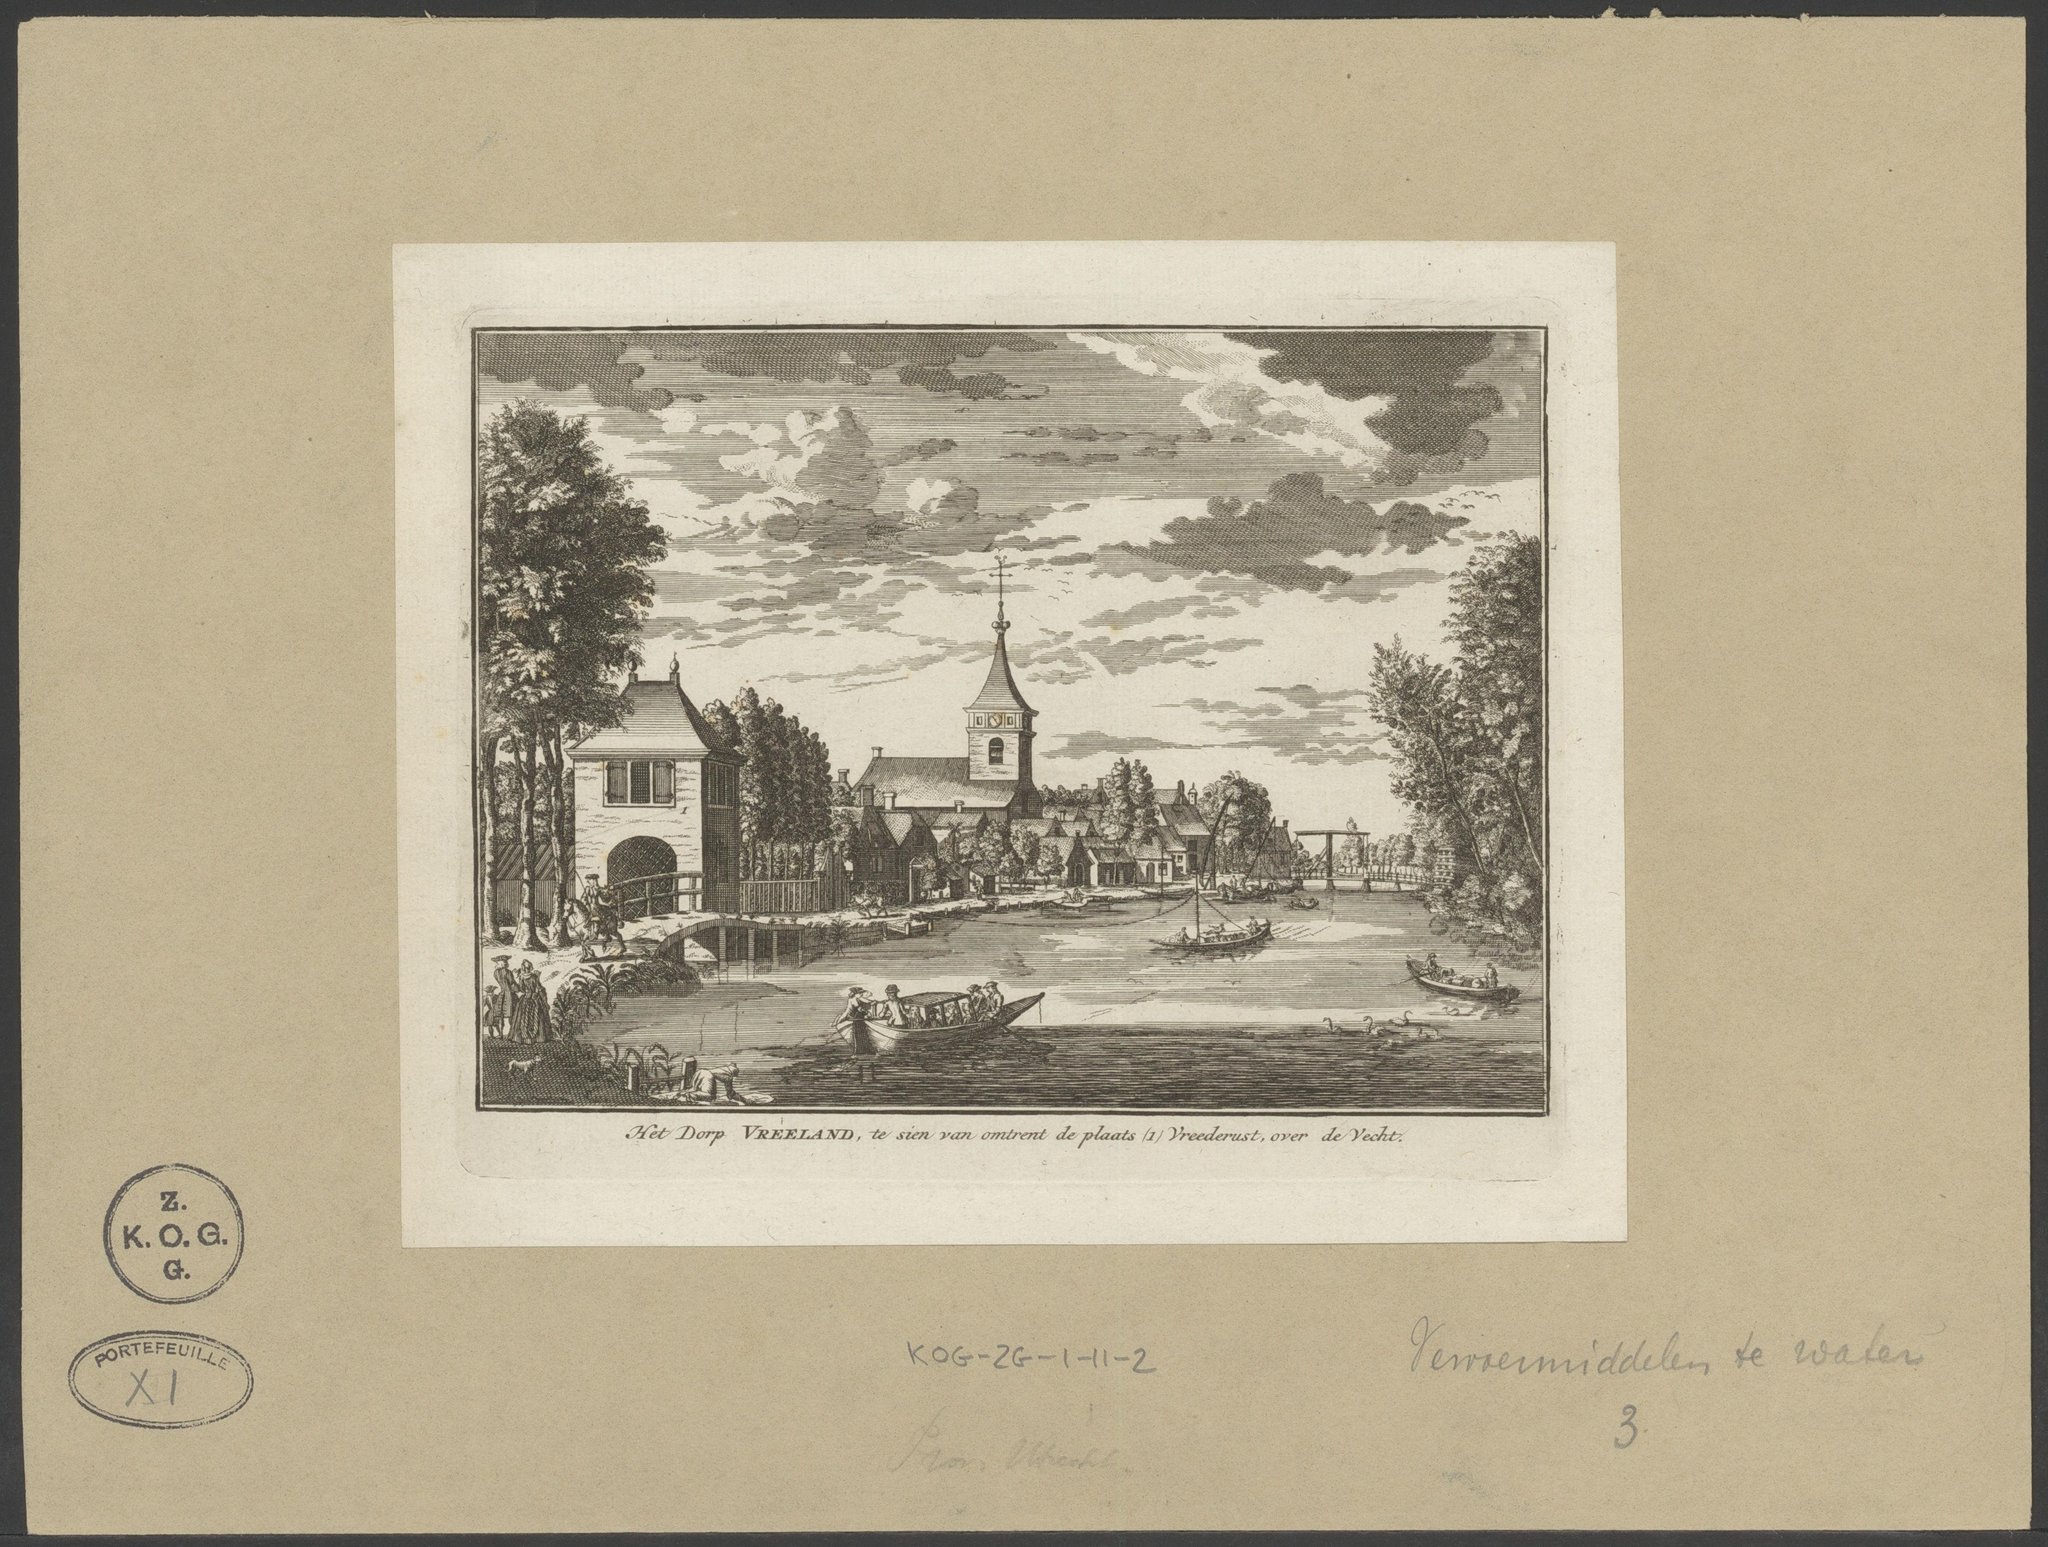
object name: print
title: Gezicht op de buitenplaats Vrederust aan de Vecht in Vreeland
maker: Anonymous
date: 1719-1729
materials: paper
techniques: engraving, etching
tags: prospect of village, silhouette of village, vecht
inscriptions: stamp, collector's mark: Lugt 1641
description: Gezicht op de buitenplaats Vrederust aan de Vecht in Vreeland. Op de Vecht een trekschuit en een overdekte roeiboot. Onderwerpsrubrieken binnen de Atlas Zeden en Gewoonten: Handel, nijverheid en verkeer, Vervoermiddelen te land en te water, Vervoermiddelen te water.